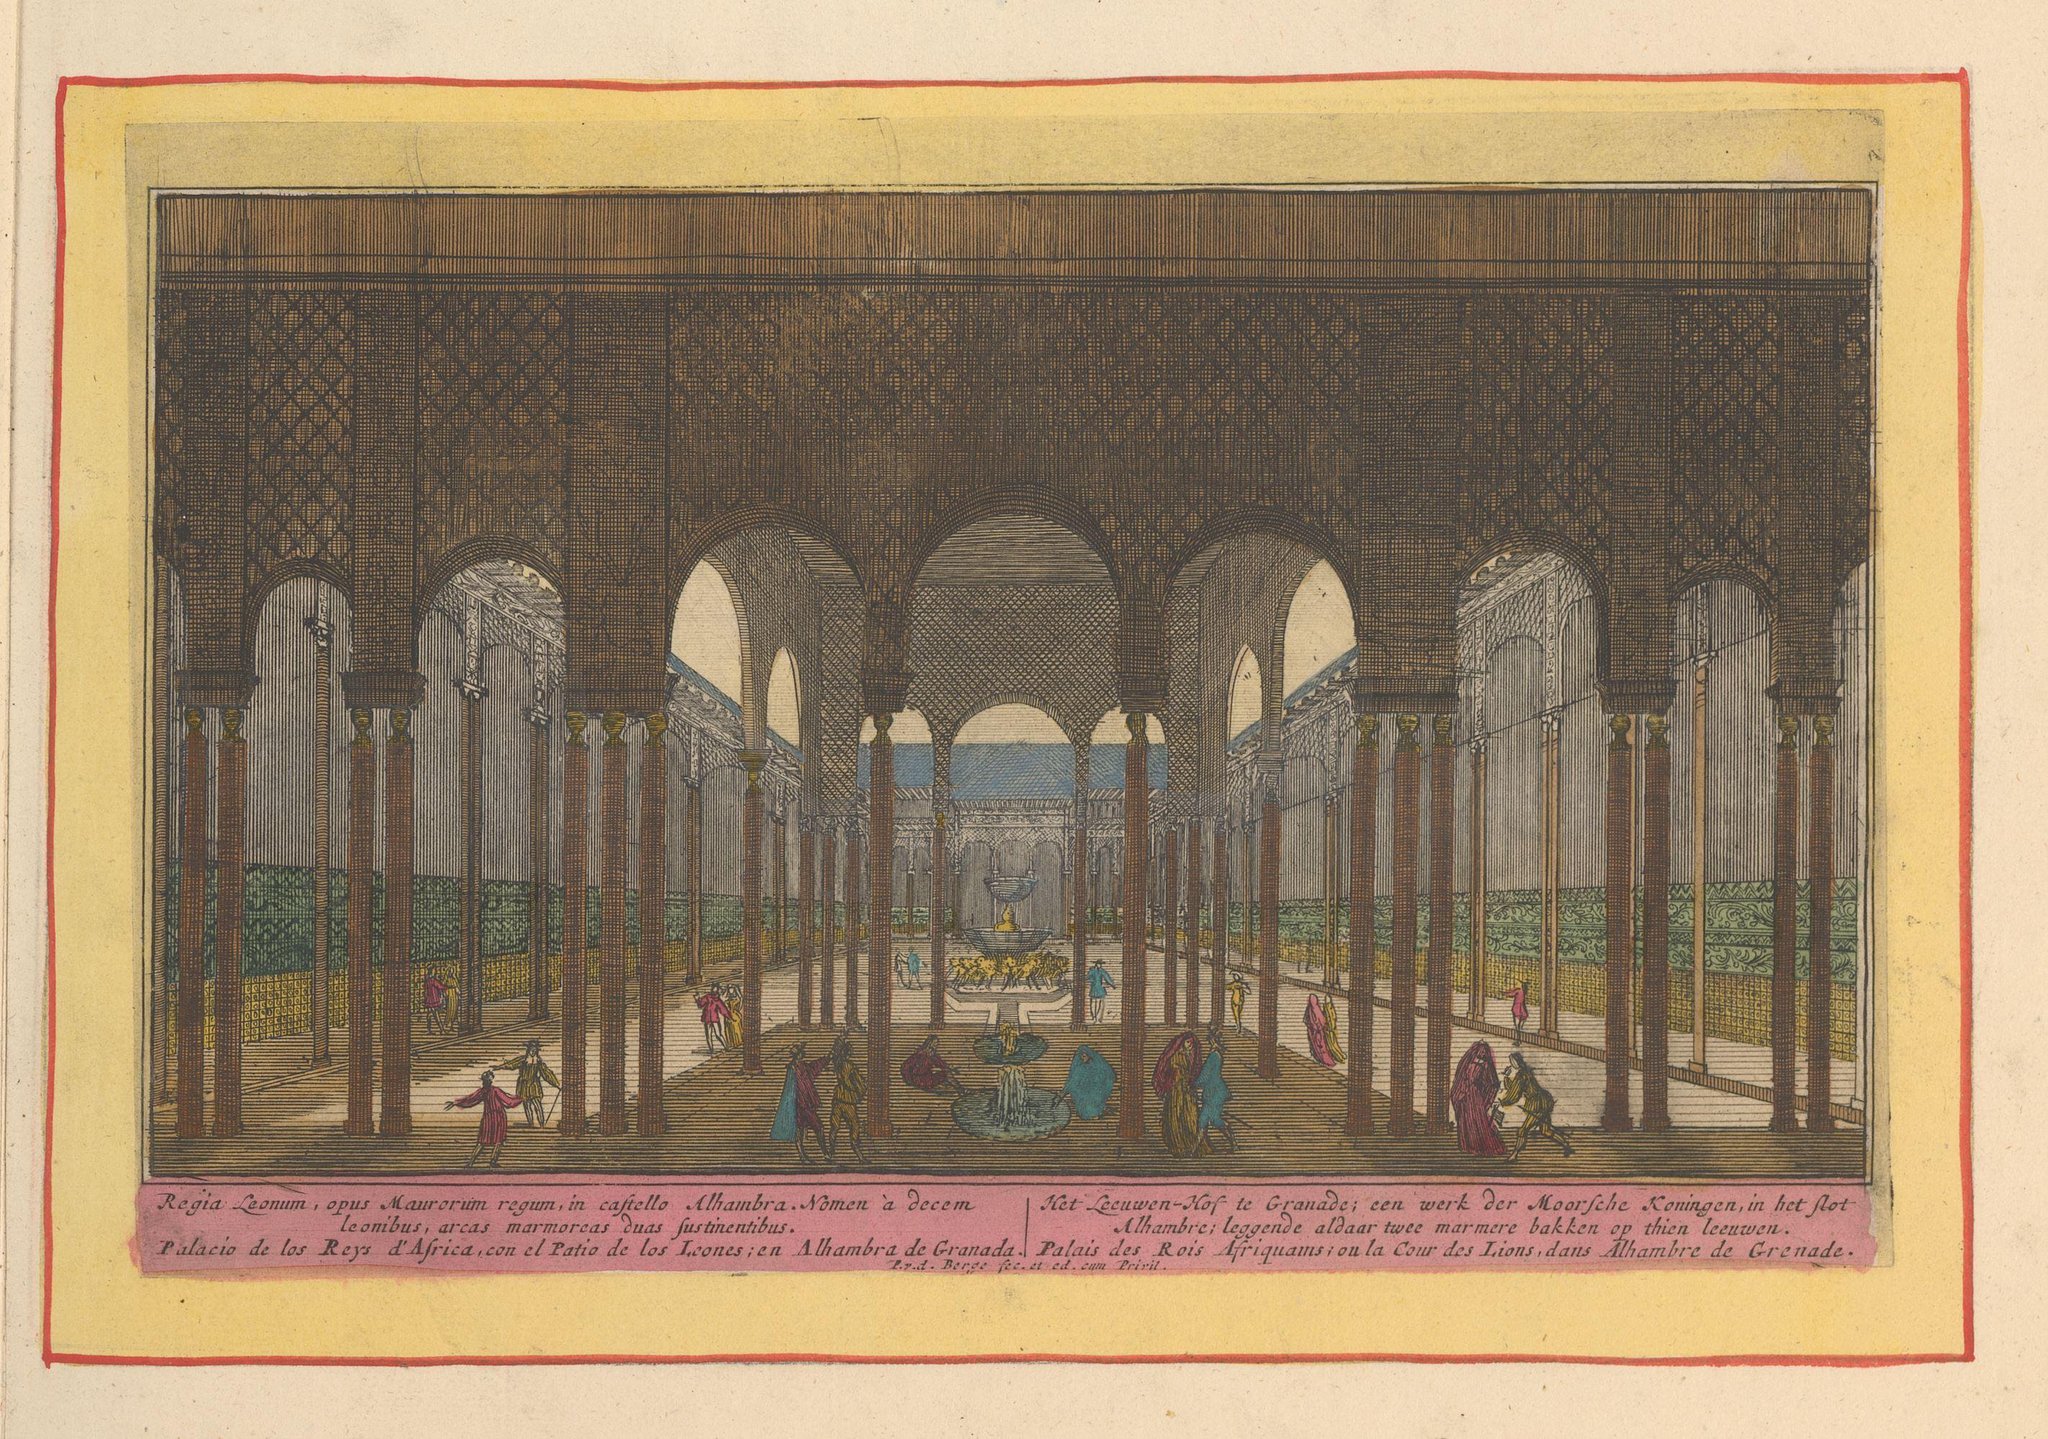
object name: print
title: Gezicht op de leeuwenhof in het Alhambra te Granada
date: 1694-1737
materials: paper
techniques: etching, hand coloring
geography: amsterdam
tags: courtyard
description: Prent uit: Theatrum Hispaniæ, exhibens regni urbes, villas ac viridaria magis illustria. Het aanmerkelykste en voortreffelykste in Spanjen (...). Amsterdam: Pieter van den Berge, ca. 1694-1737.